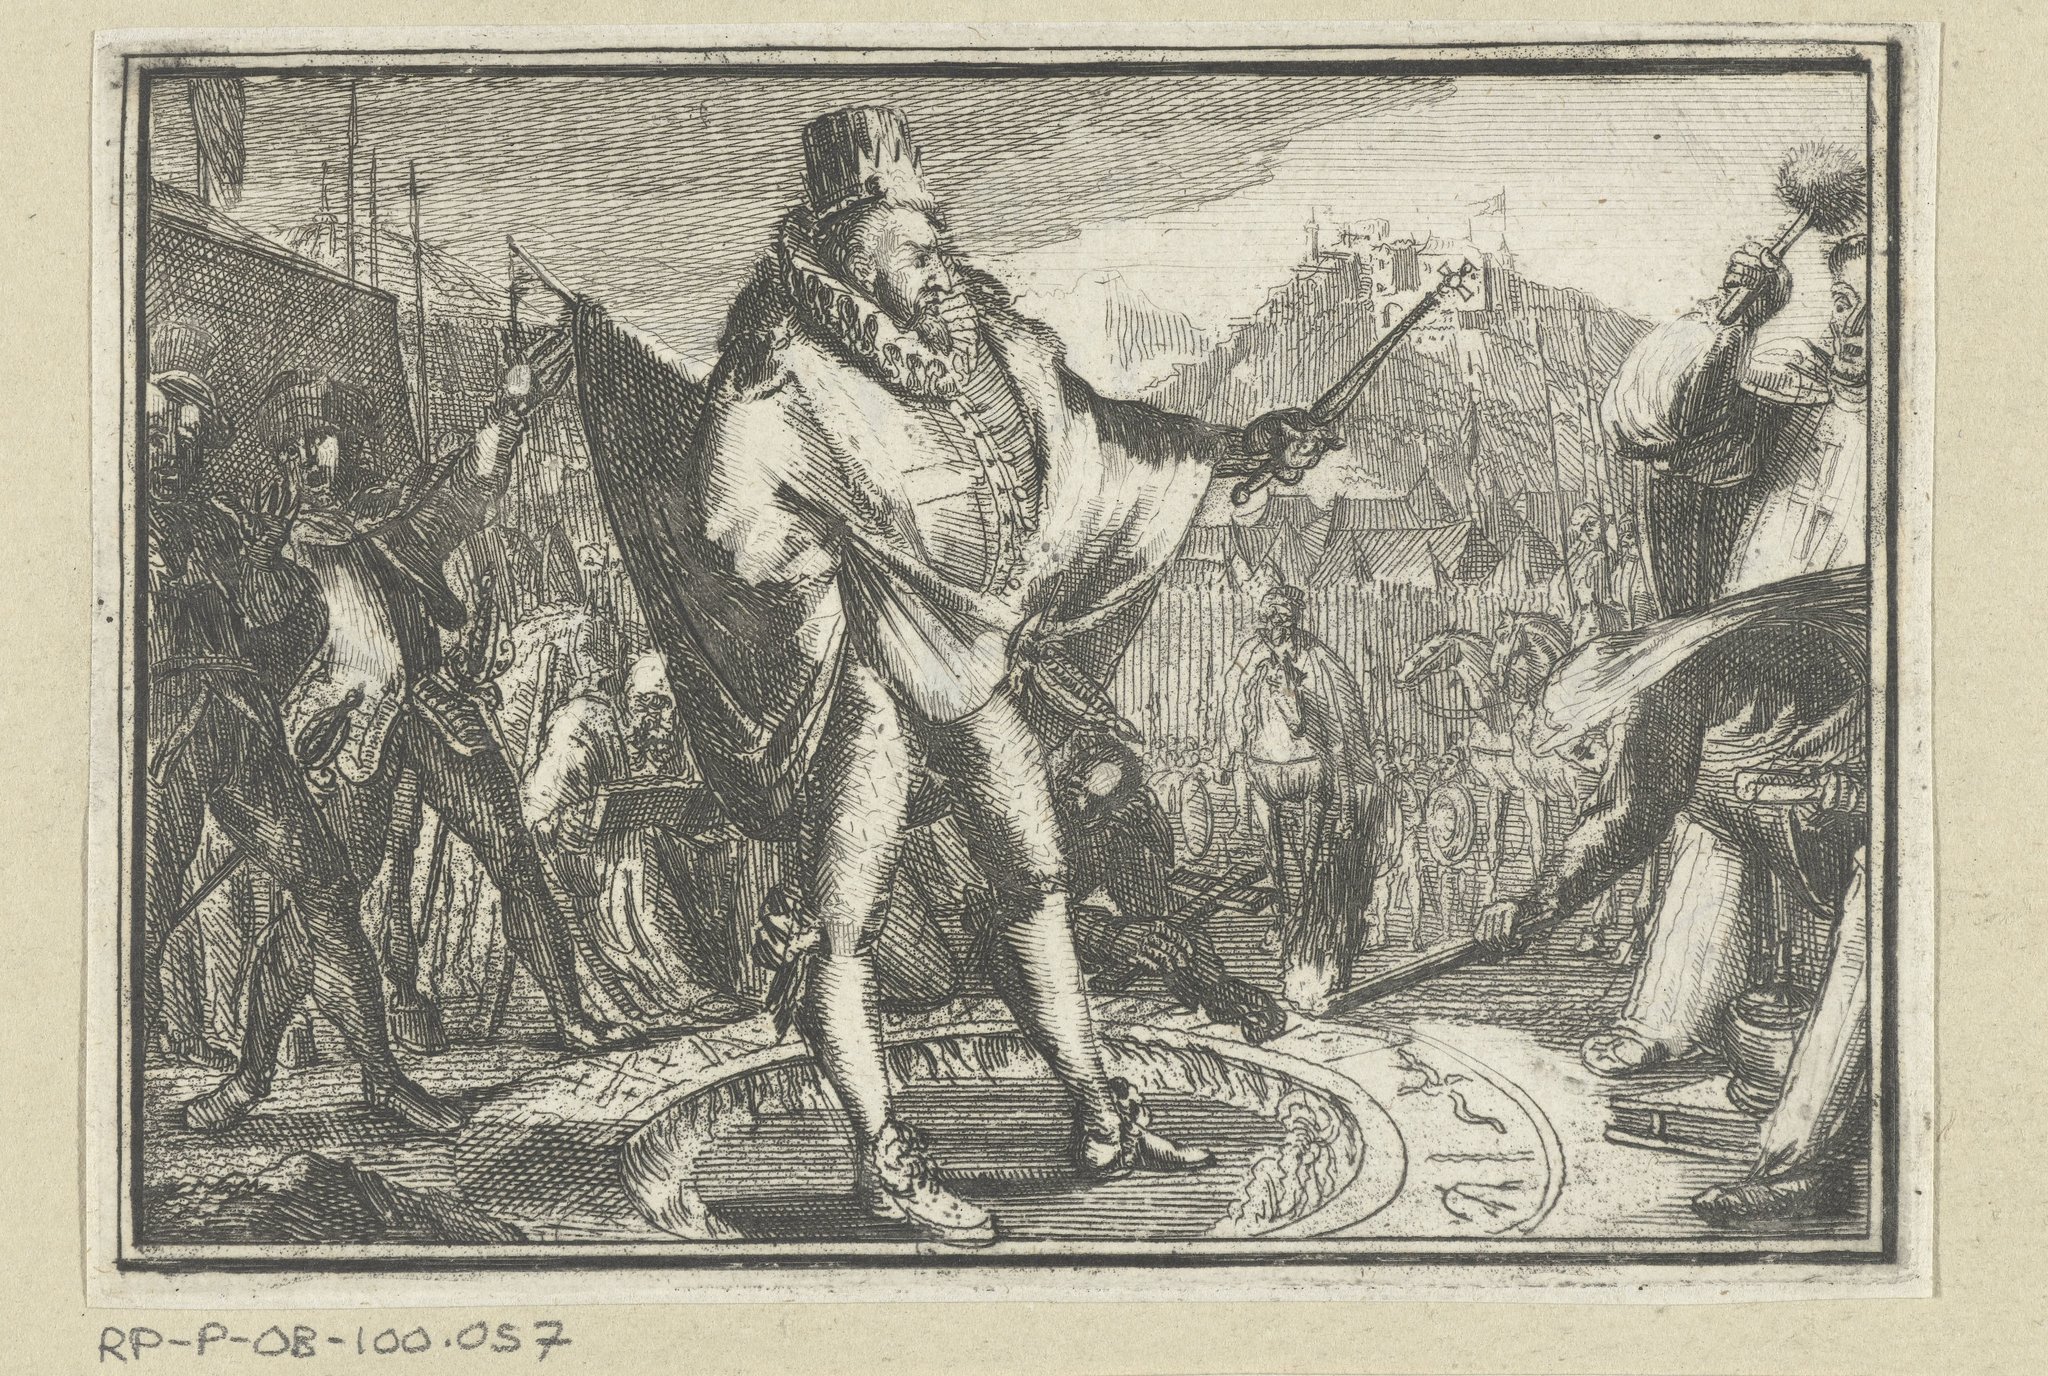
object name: print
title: Esopus in Europa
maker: romeyn de hooghe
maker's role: draughtsman, goldsmith, painter, print maker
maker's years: 1645-1708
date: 1701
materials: paper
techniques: etching, letterpress printing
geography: netherlands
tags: karel ii (koning van spanje)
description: De schim van de overleden koning Karel II verschijnt in het midden van een cirkel met magische tekens. Titel staat op apart tekstblad.